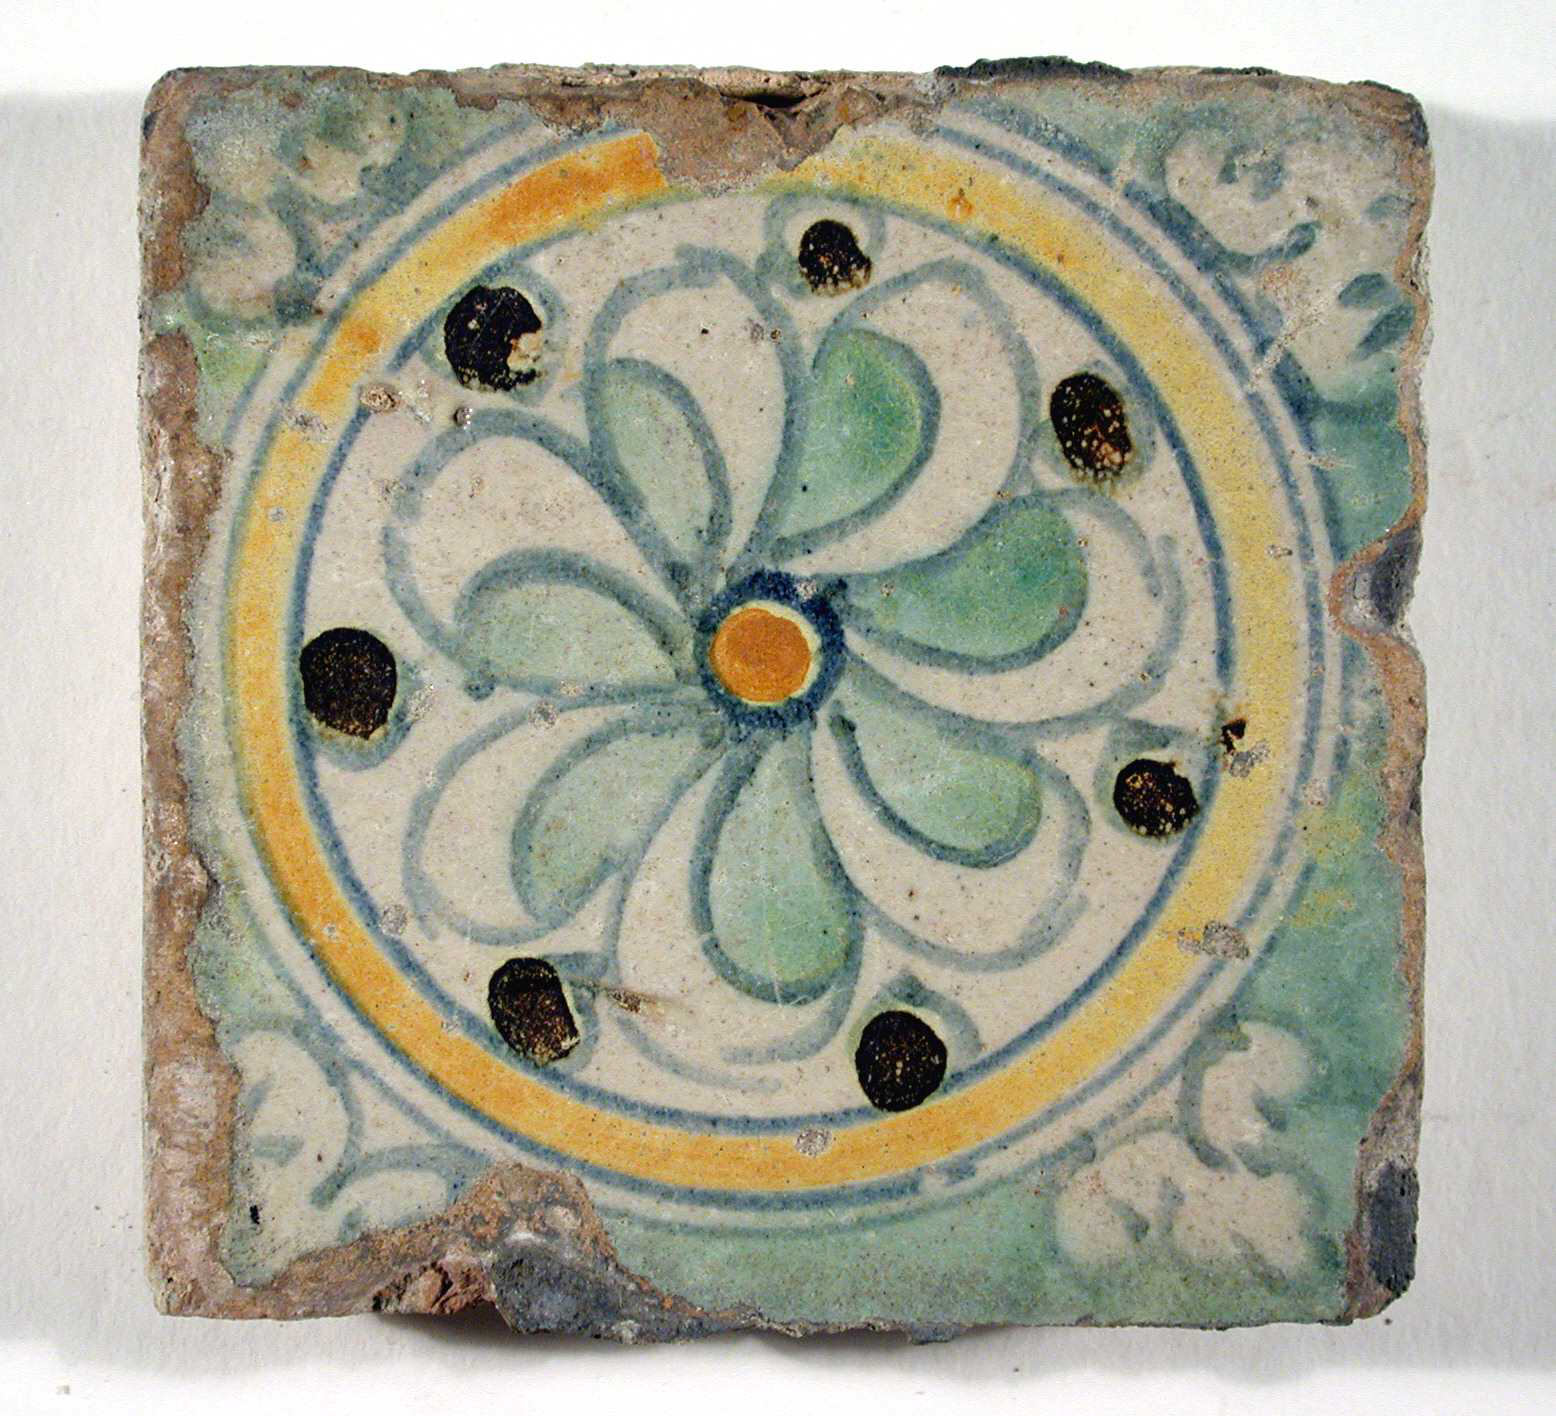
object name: tile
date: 1501-1700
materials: earthenware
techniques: glazing